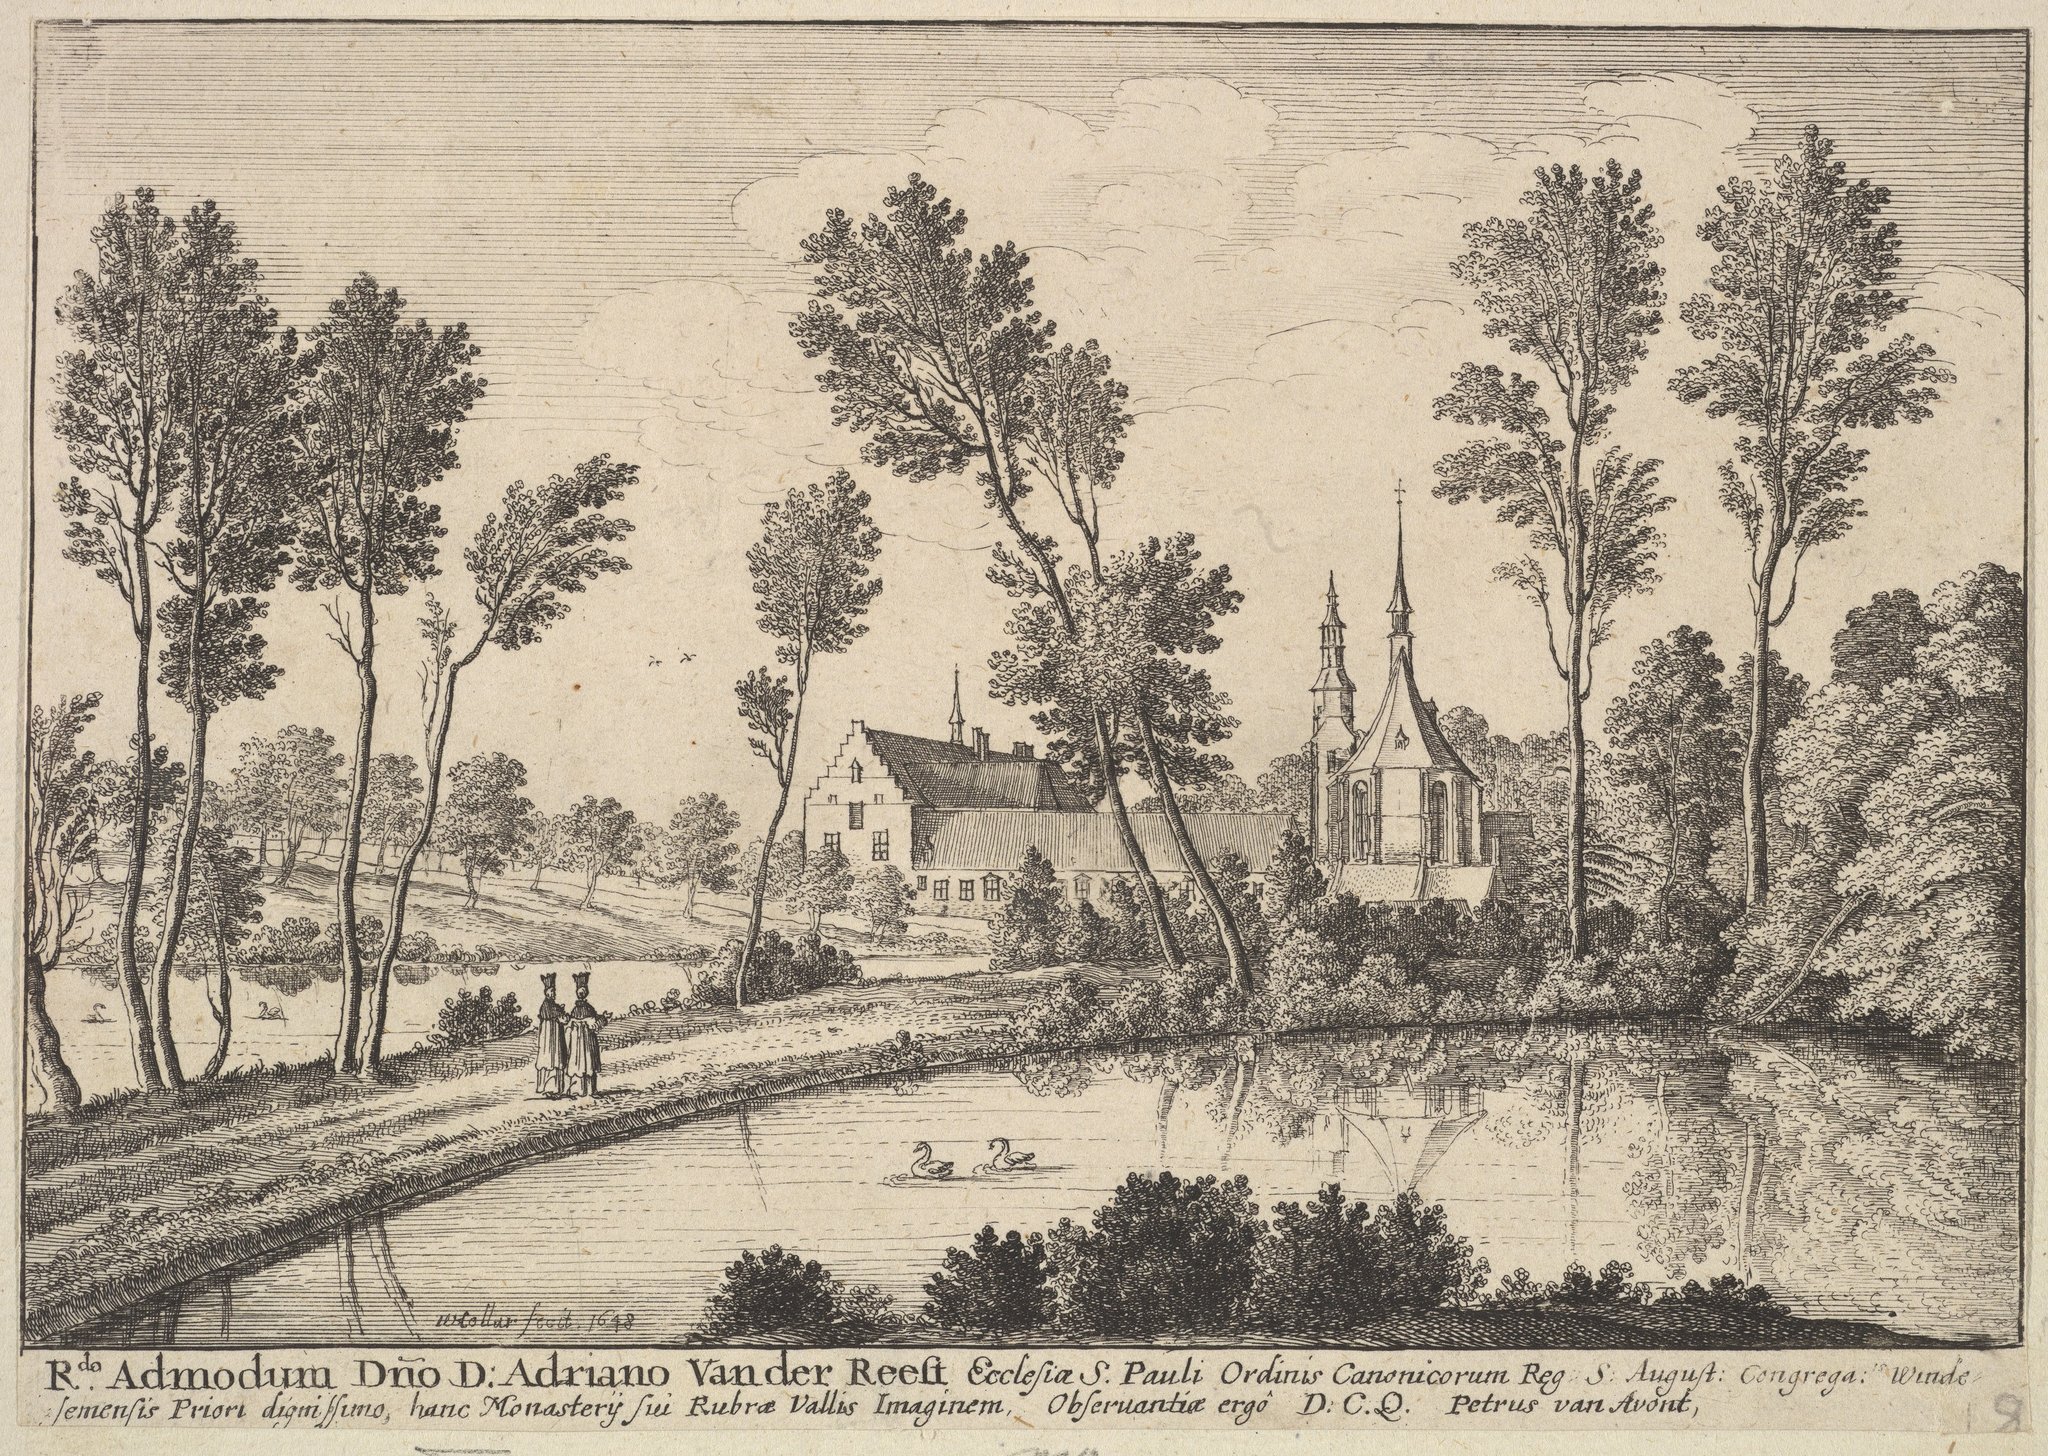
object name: print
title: Rothendael Abbey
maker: wenceslaus hollar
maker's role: artist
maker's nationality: bohemian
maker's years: 1607-1677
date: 1648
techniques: etching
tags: churches,swans,rivers,landscapes